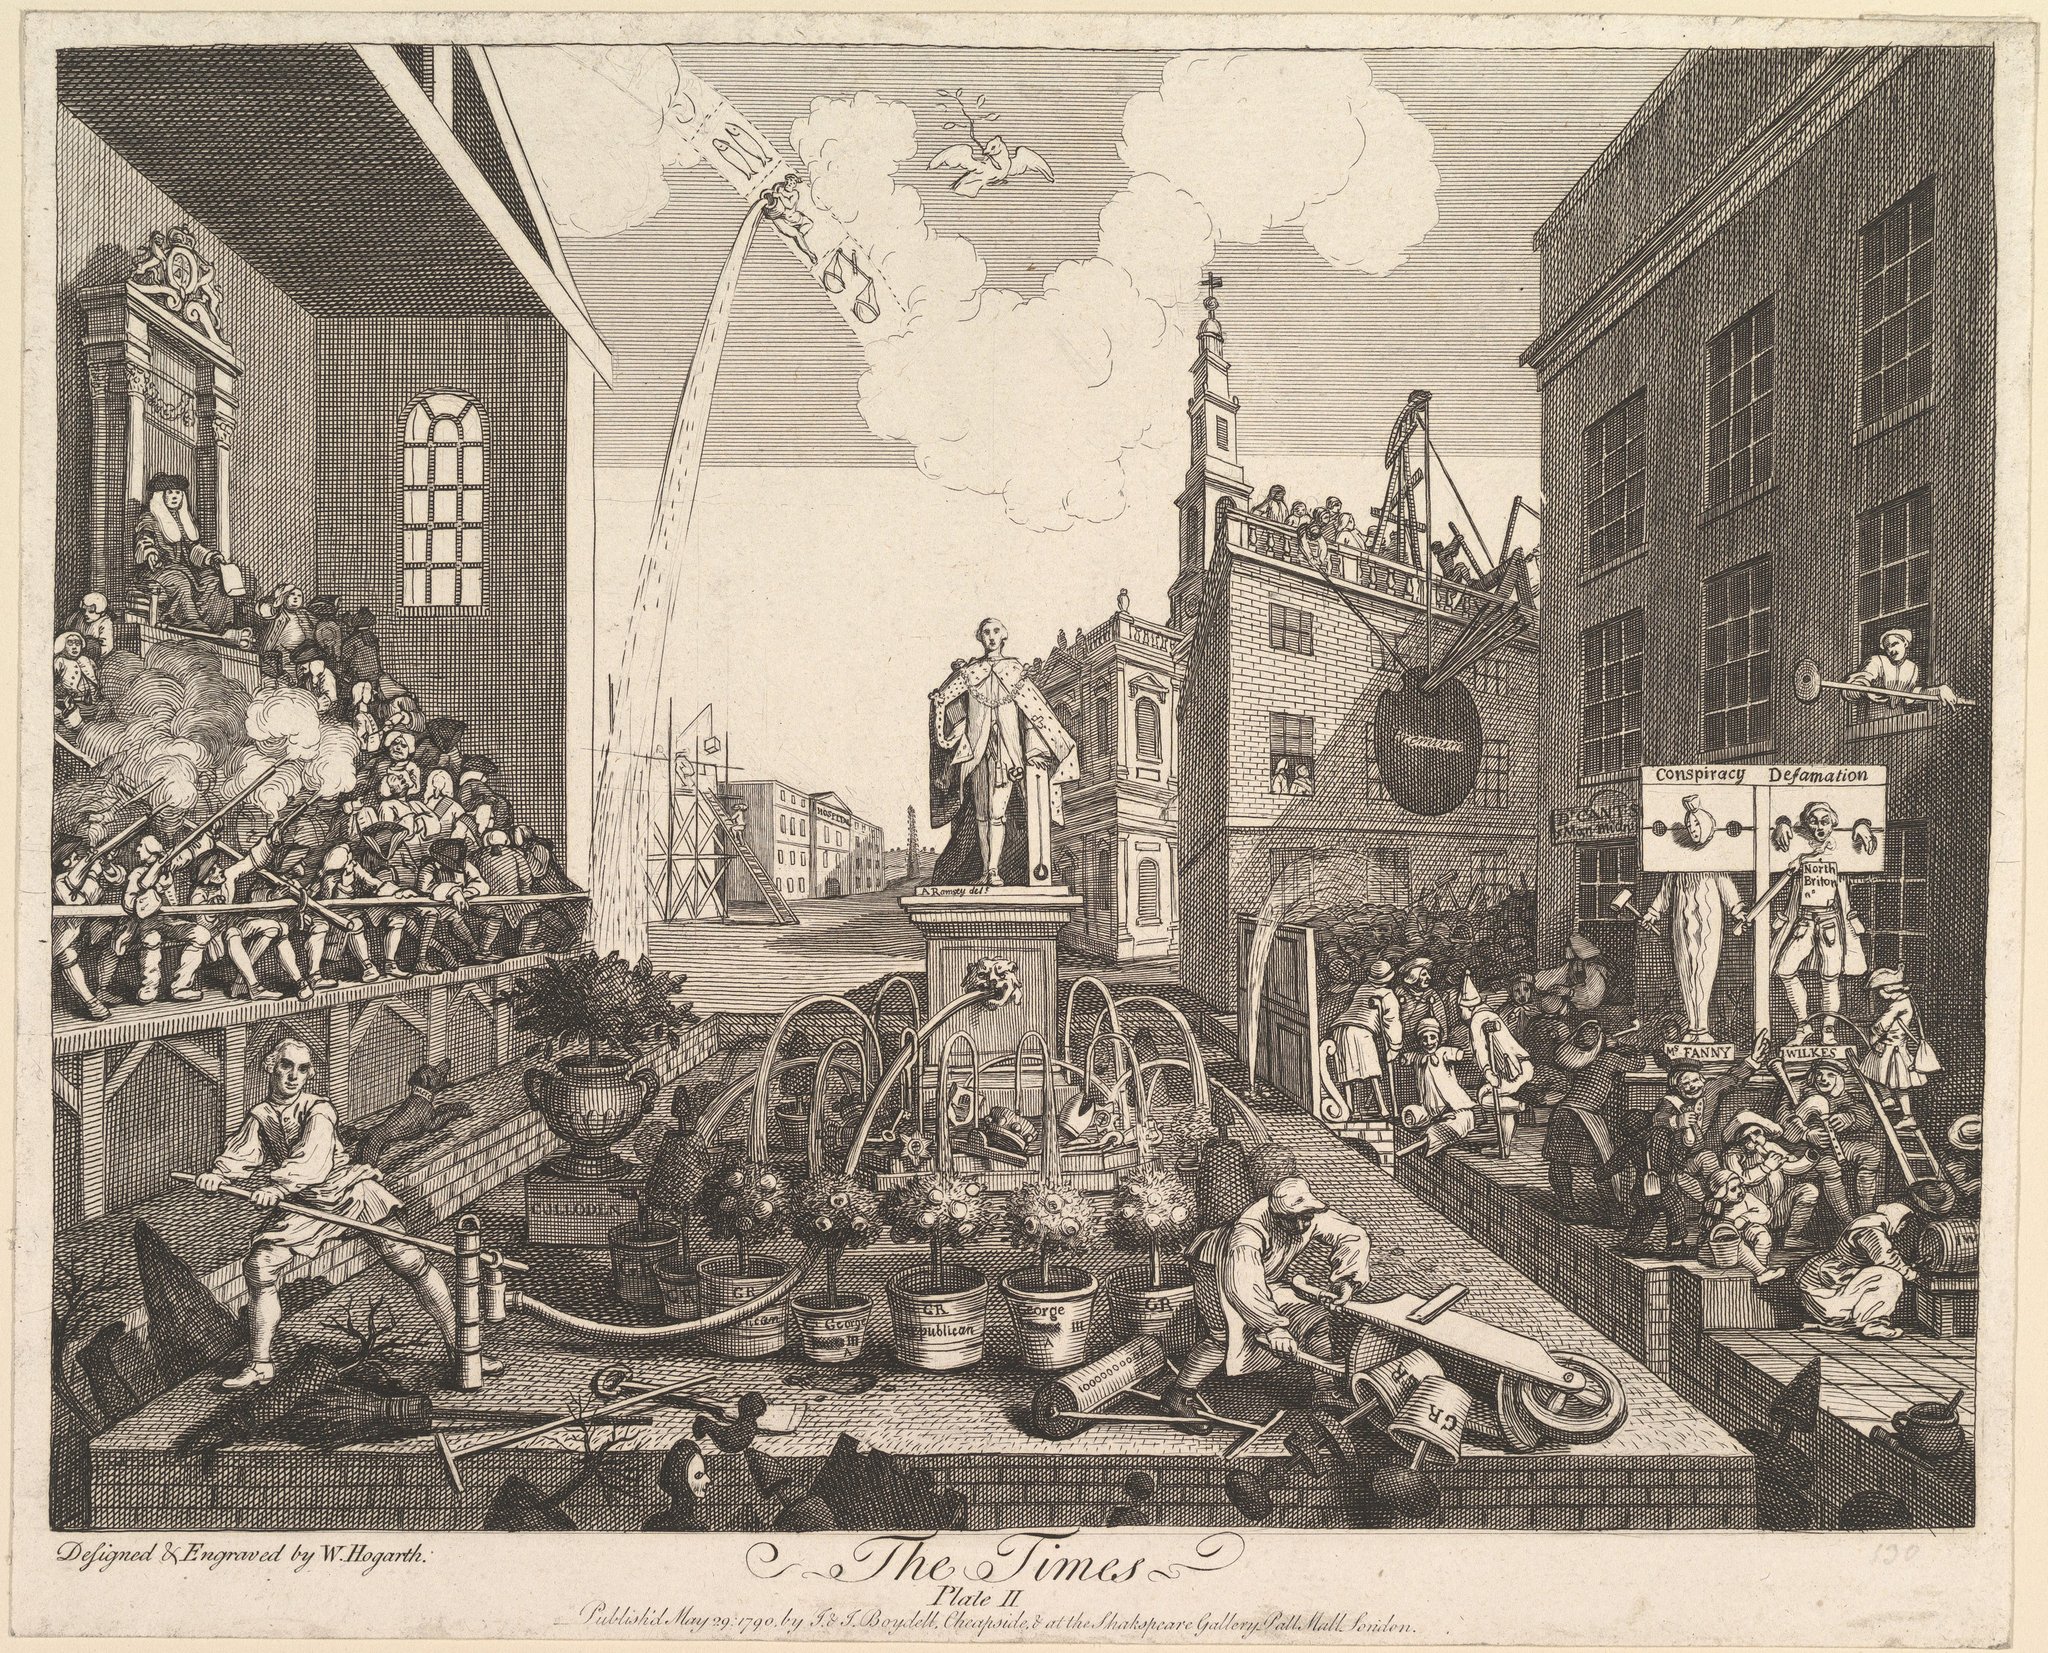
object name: print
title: The Times, Plate 2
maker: william hogarth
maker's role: artist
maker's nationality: british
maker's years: 1697-1764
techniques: engraving, etching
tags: satire,men,women,dogs,london